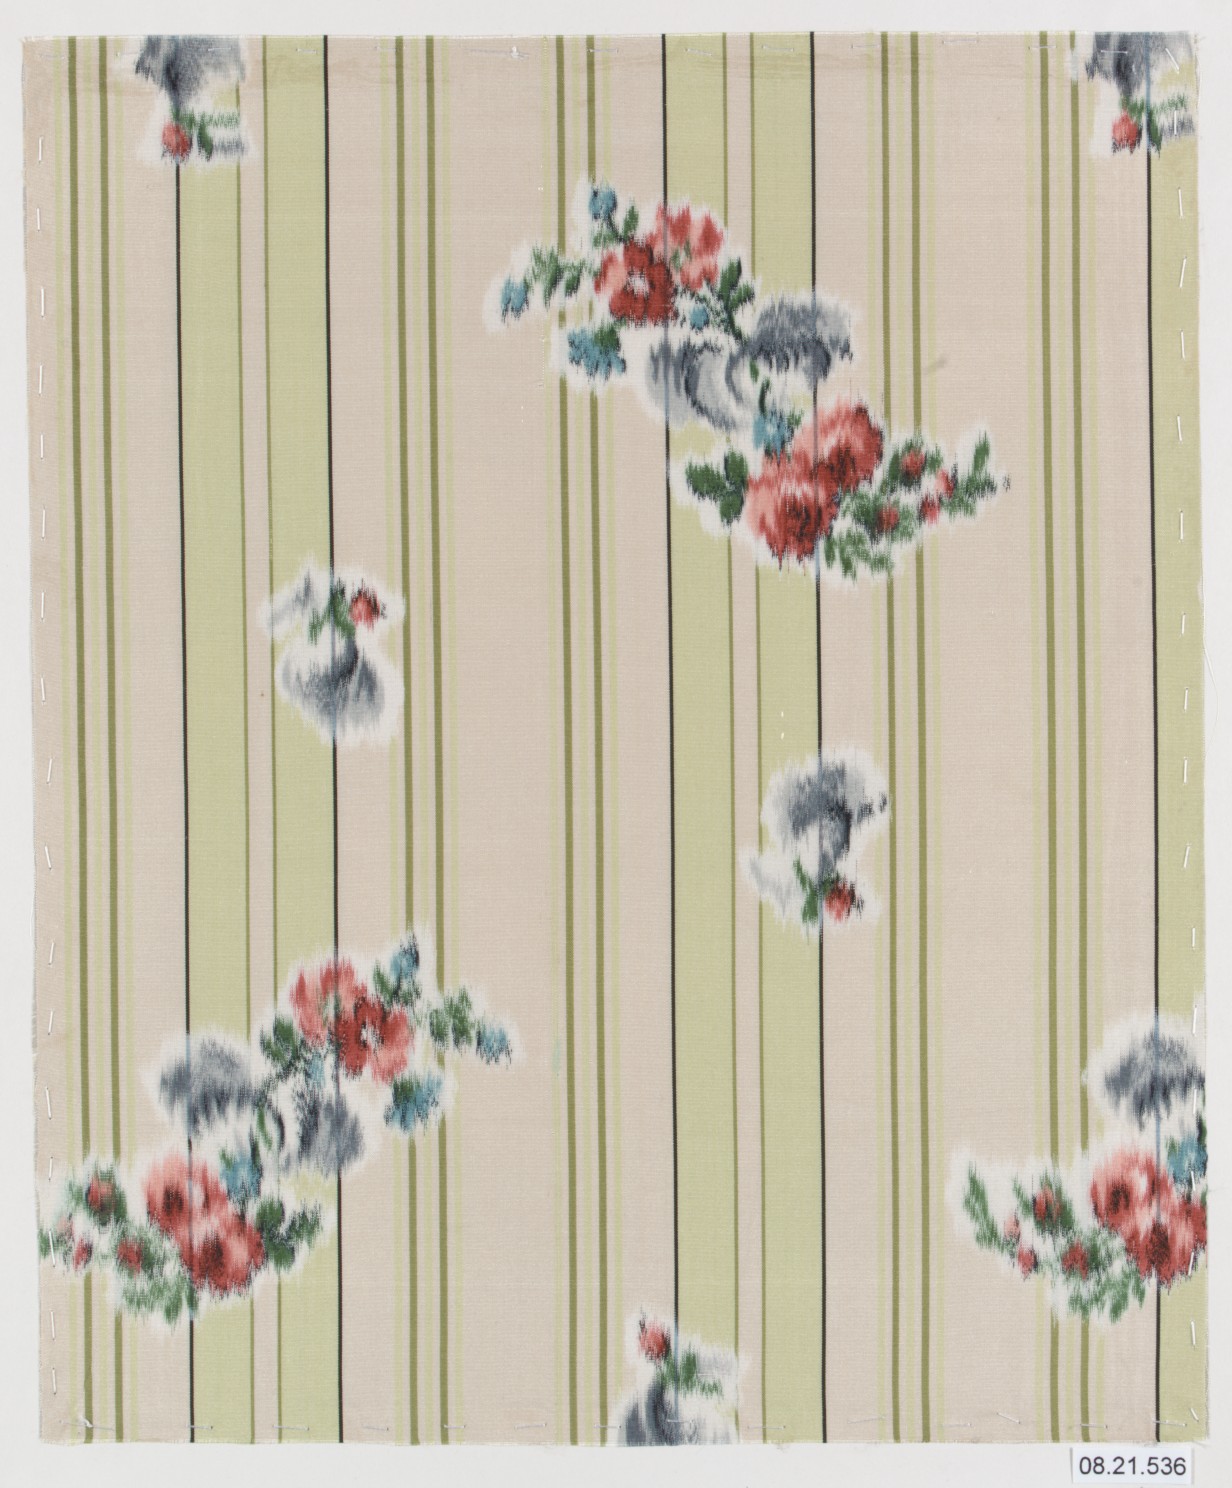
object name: textile sample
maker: Anonymous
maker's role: designer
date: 1900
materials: silk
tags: flowers